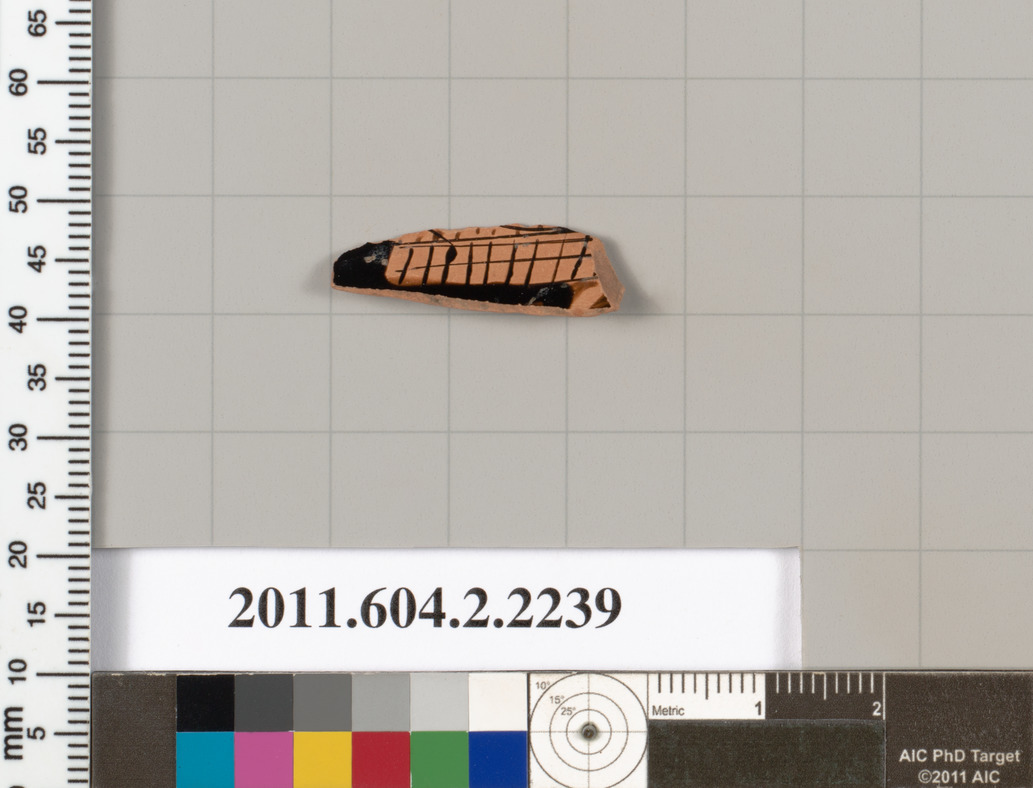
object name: pot fragment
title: Terracotta fragment of a pot; unglazed on the inside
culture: greek, attic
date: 460-440 BCE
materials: terracotta